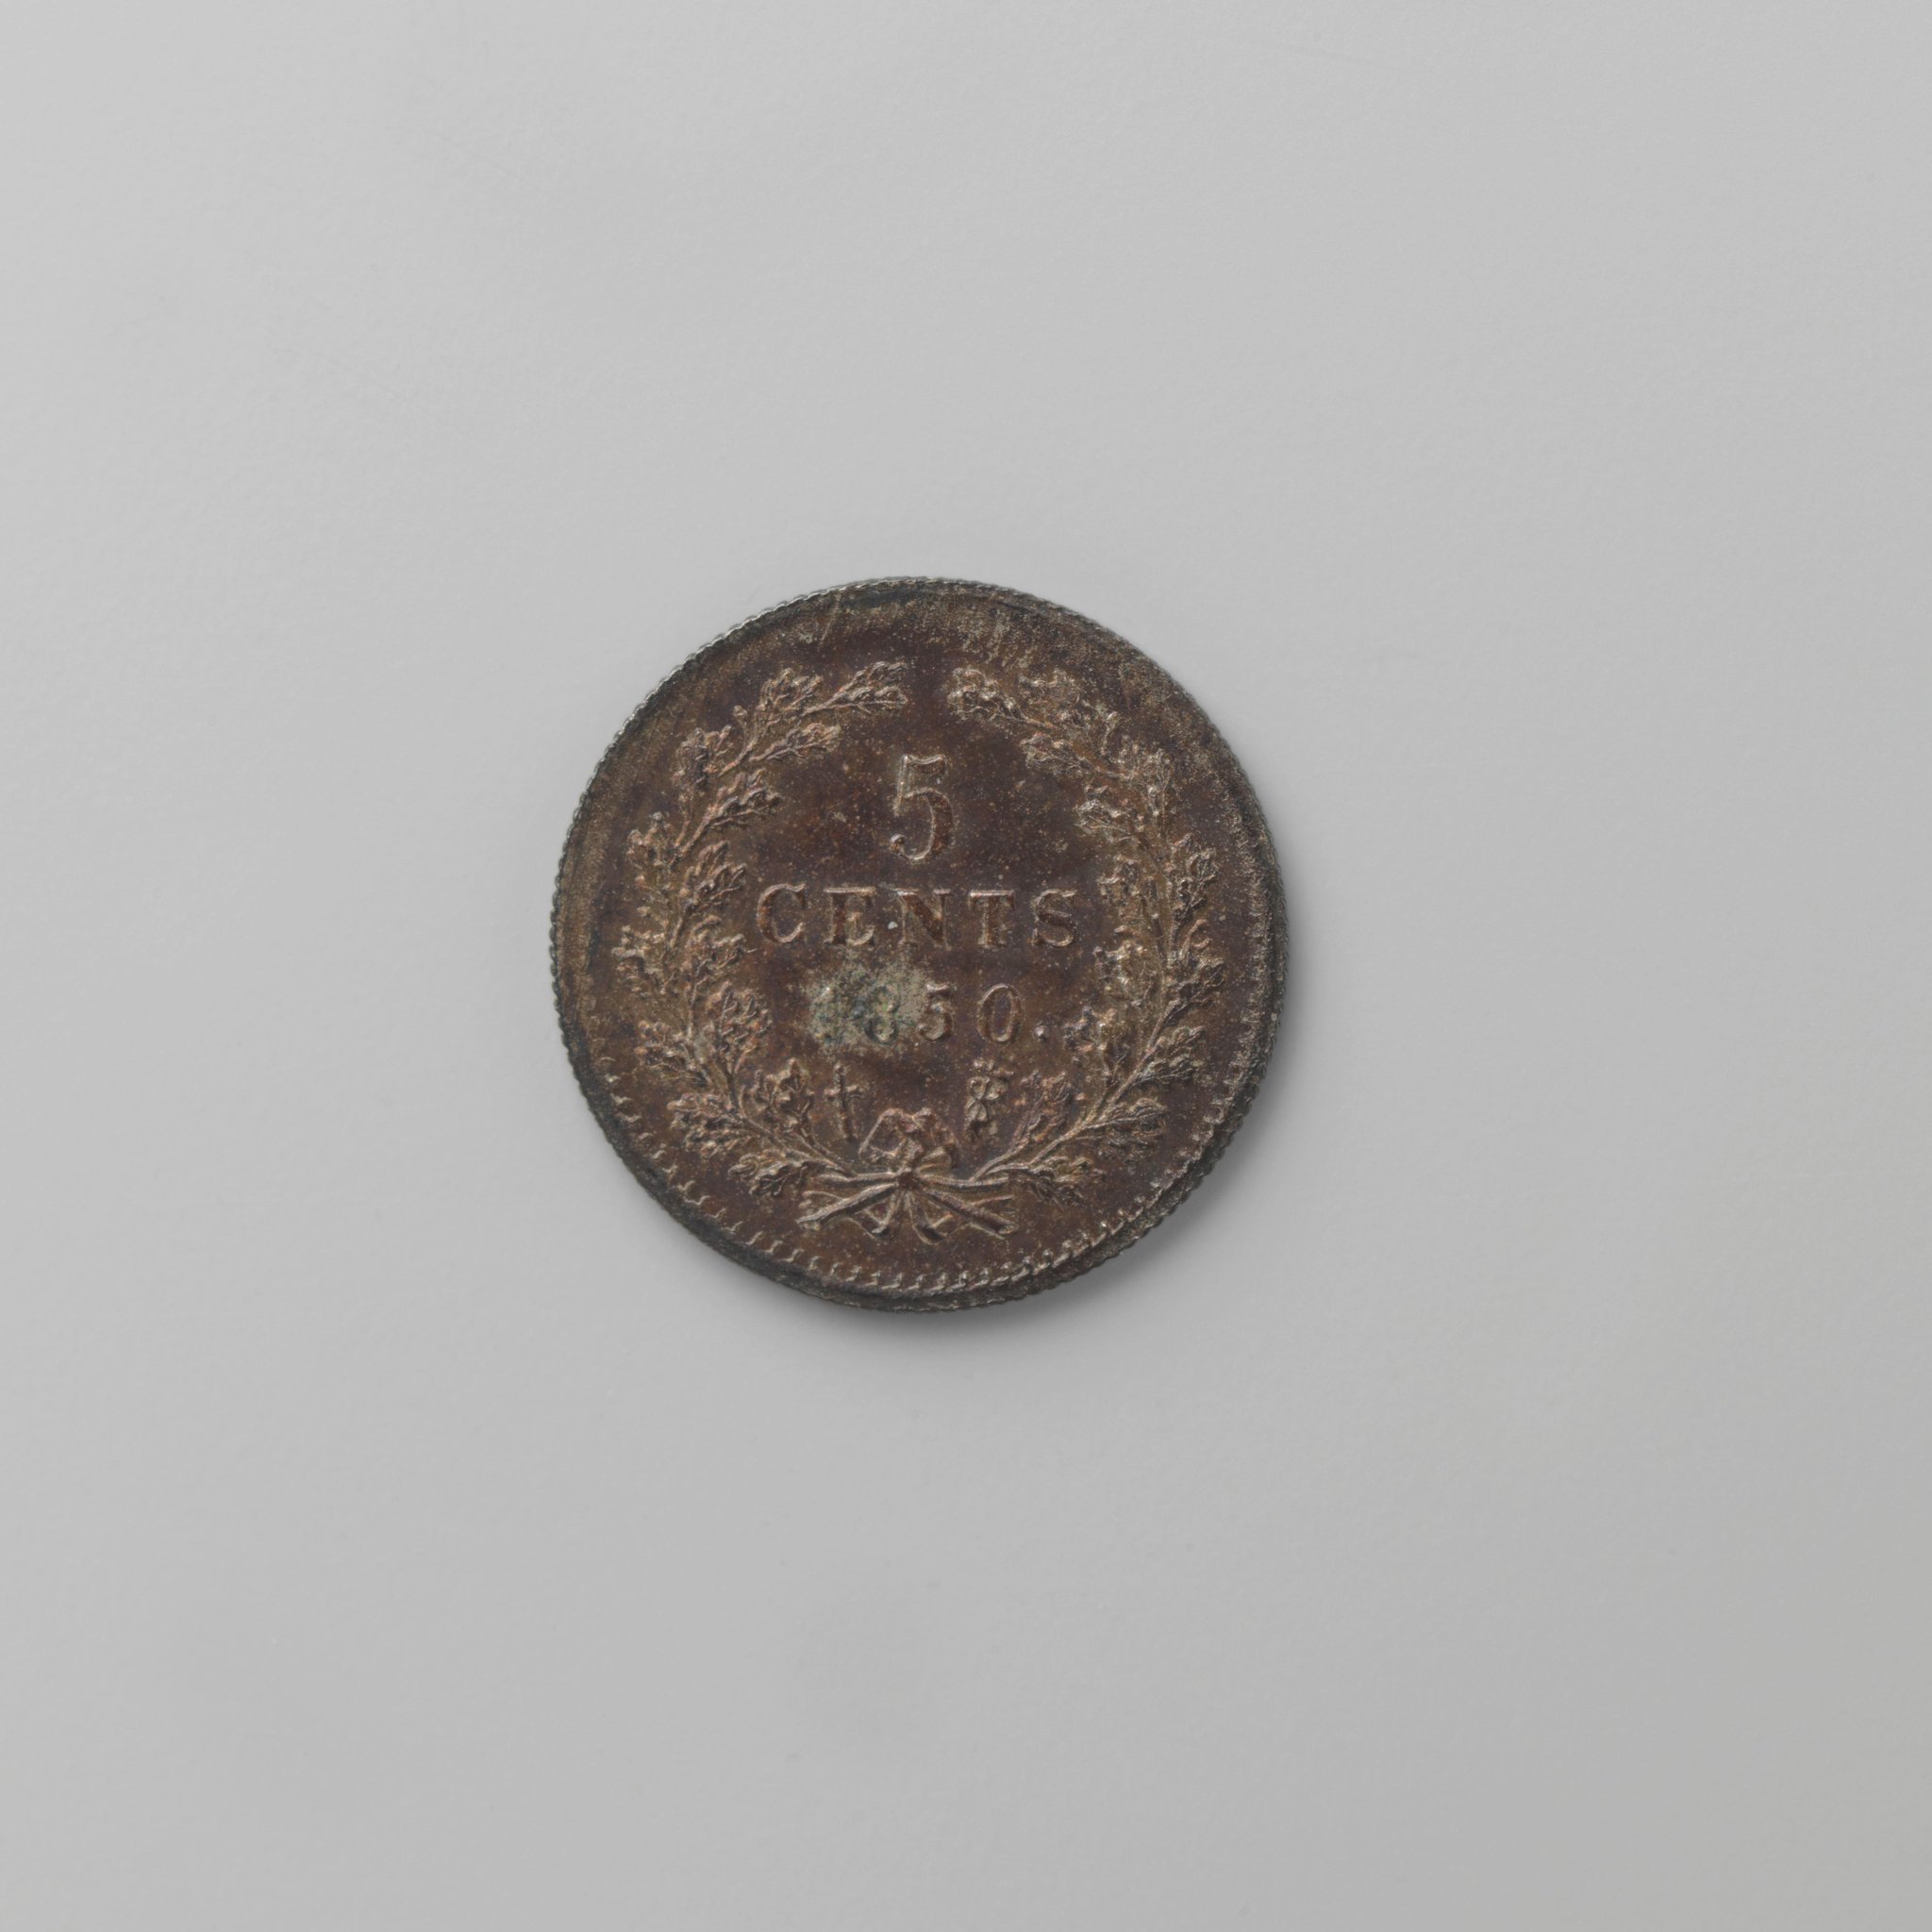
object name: coin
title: Nederland, 5 cent, 1850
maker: willem iii (koning der nederlanden)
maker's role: koning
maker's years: 1817-1890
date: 1850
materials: silver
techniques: striking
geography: utrecht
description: Zilveren munt. Voorzijde: borstbeeld naar rechts. Keerzijde: binnen twee samengebonden eikentakken waarde-aanduiding 5 cents. Daaronder jaartal. Kartelrand.